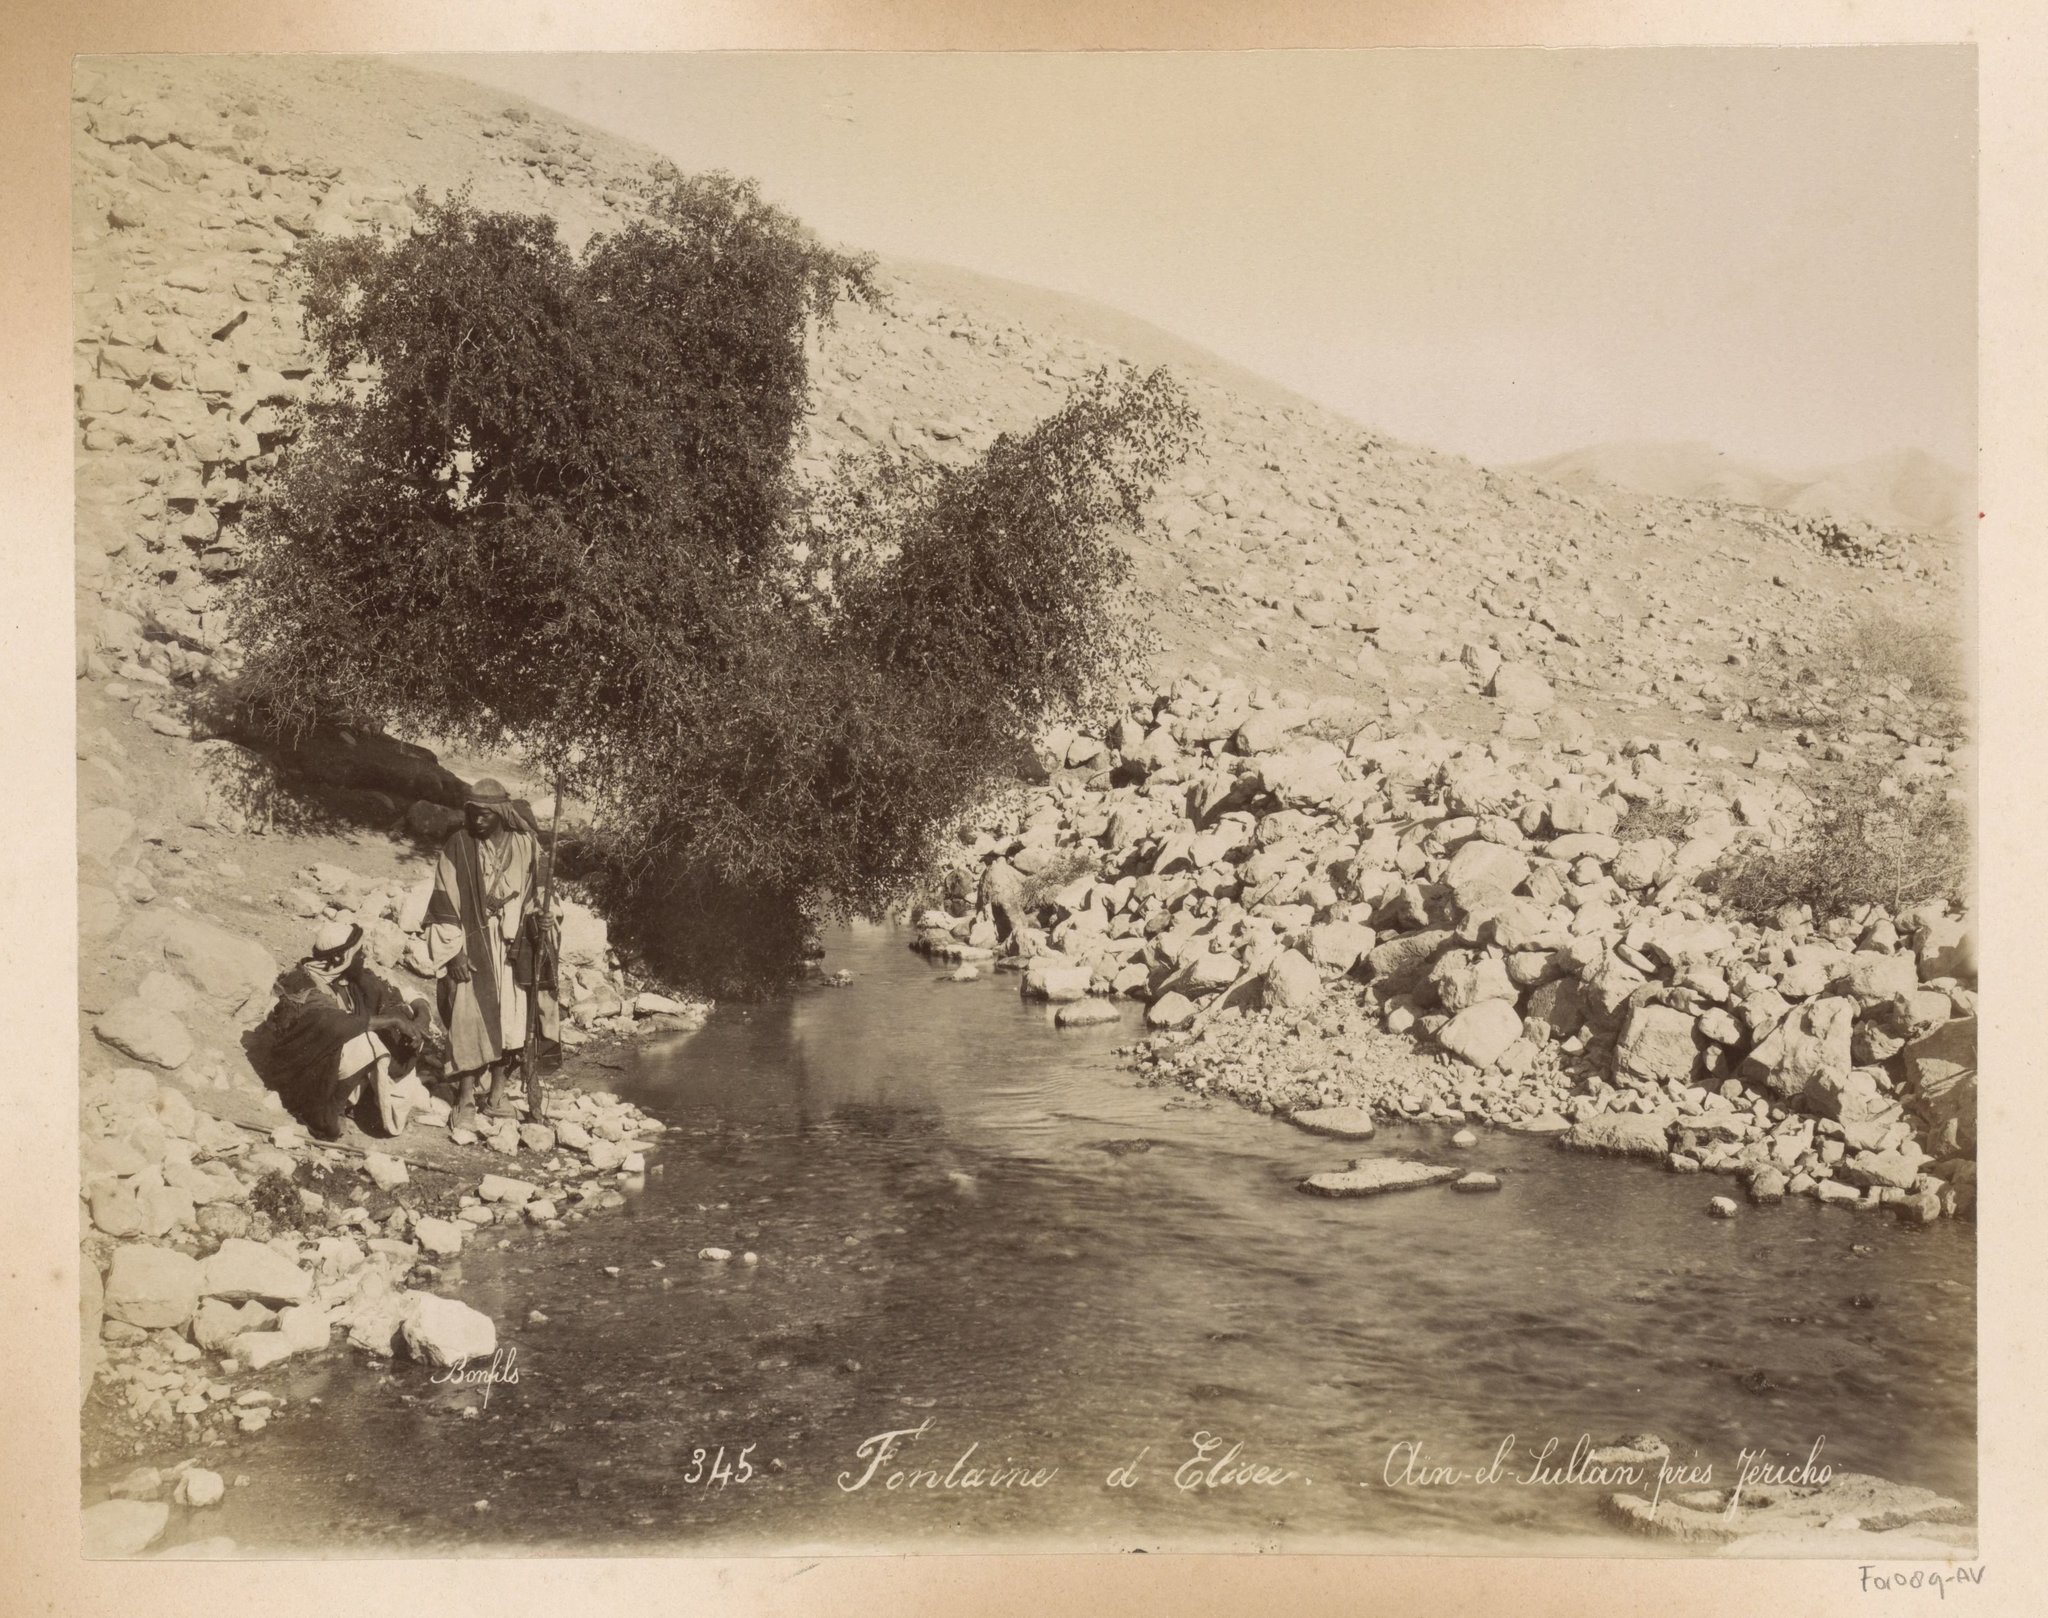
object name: photograph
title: Fontaine d Elisee. - Aïn-el-Sultan, près Jéricho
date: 1867-1895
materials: cardboard, paper, photographic support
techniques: albumen print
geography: jericho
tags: well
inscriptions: negative number: ‘345’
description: Onderdeel van Reisalbum met foto's van Jeruzalem en andere bijbelse plaatsen.